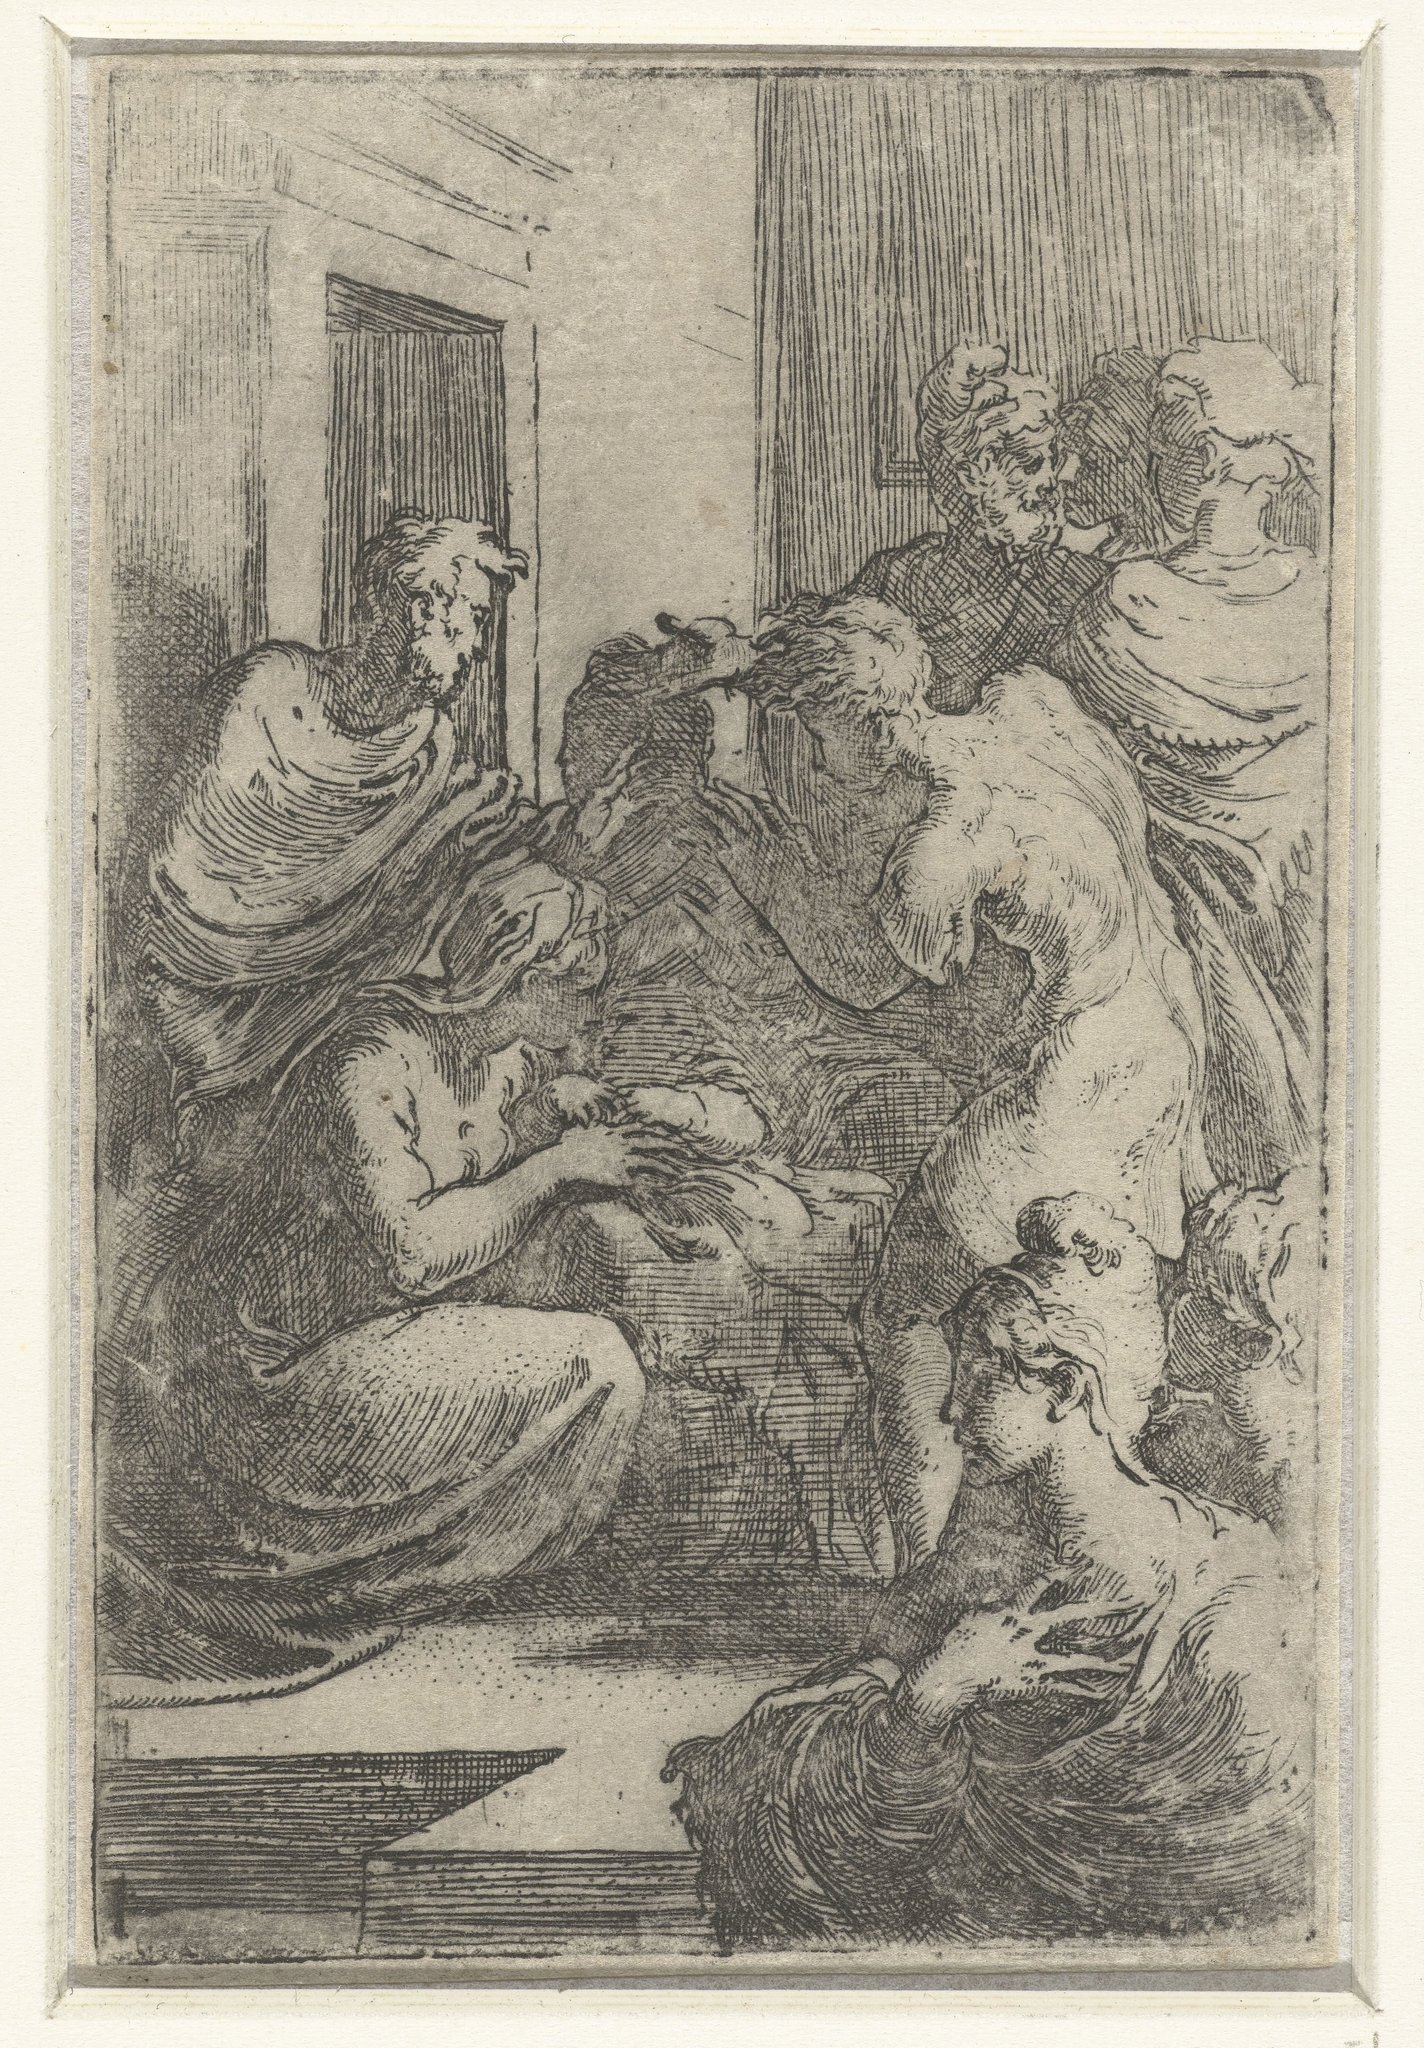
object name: print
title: Aanbidding door de herders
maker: parmigianino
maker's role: draughtsman, painter, print maker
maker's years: 1503-1540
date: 1524-1540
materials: paper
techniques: etching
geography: rome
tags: adoration of the christ-child by the shepherds; mary and joseph present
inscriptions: collector's mark: Lugt 240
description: Een groep herders en Maria en Jozef rond de kribbe met het Christuskind.